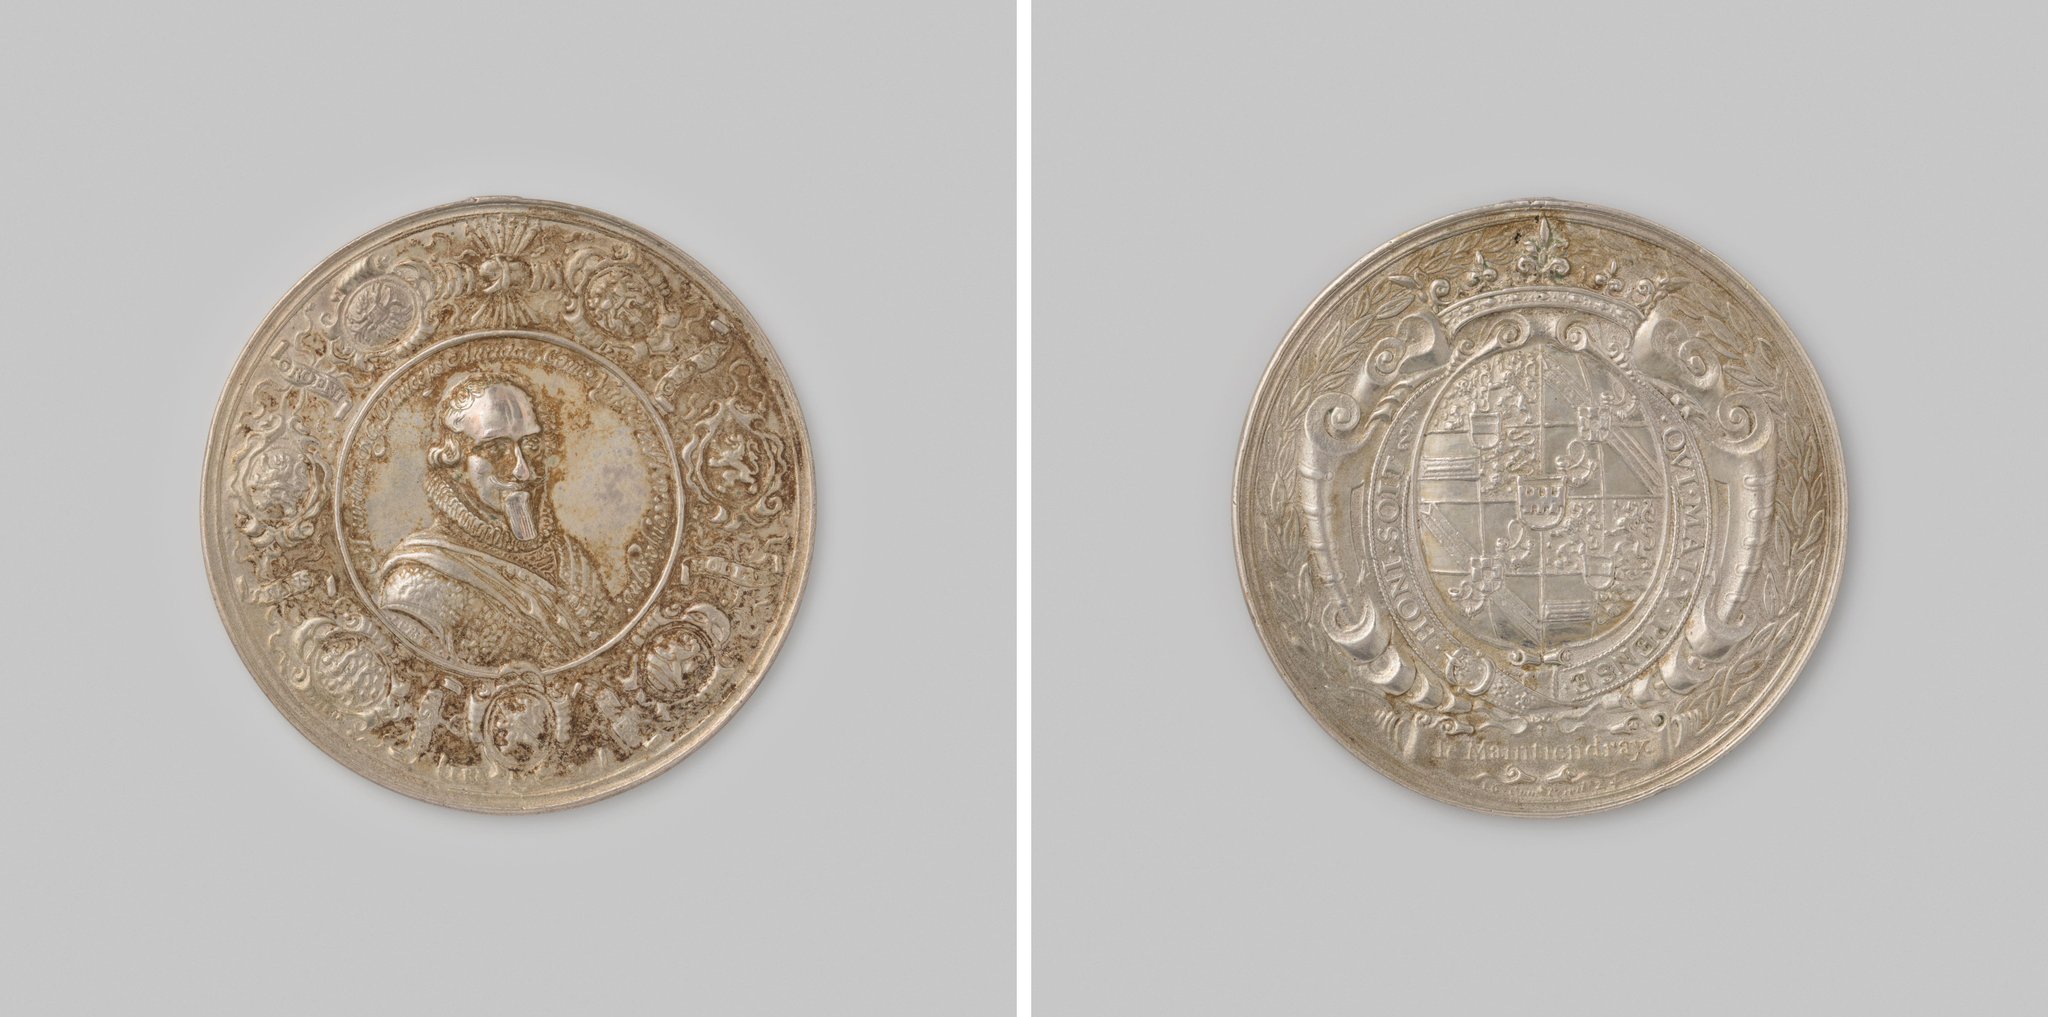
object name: history medal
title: Overwinningen in West-Indië door admiraals l'Hermite en Willems 1624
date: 1624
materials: silver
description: Zilveren penning, op de voorzijde het borstbeeld van Prins Maurits half naar rechts met omschrift binnen een brede rand met zeven cartouches met wapenschilden door lint verbonden waartussen banderols, met bovenaan twee ineengeslagen handen op een pijlenbundel, op de keerzijde een gekroonde cartouche met een ovalen wapenschild omhangen door de kousenband, tussen twee lauwertakken, met onderaan een banderol.